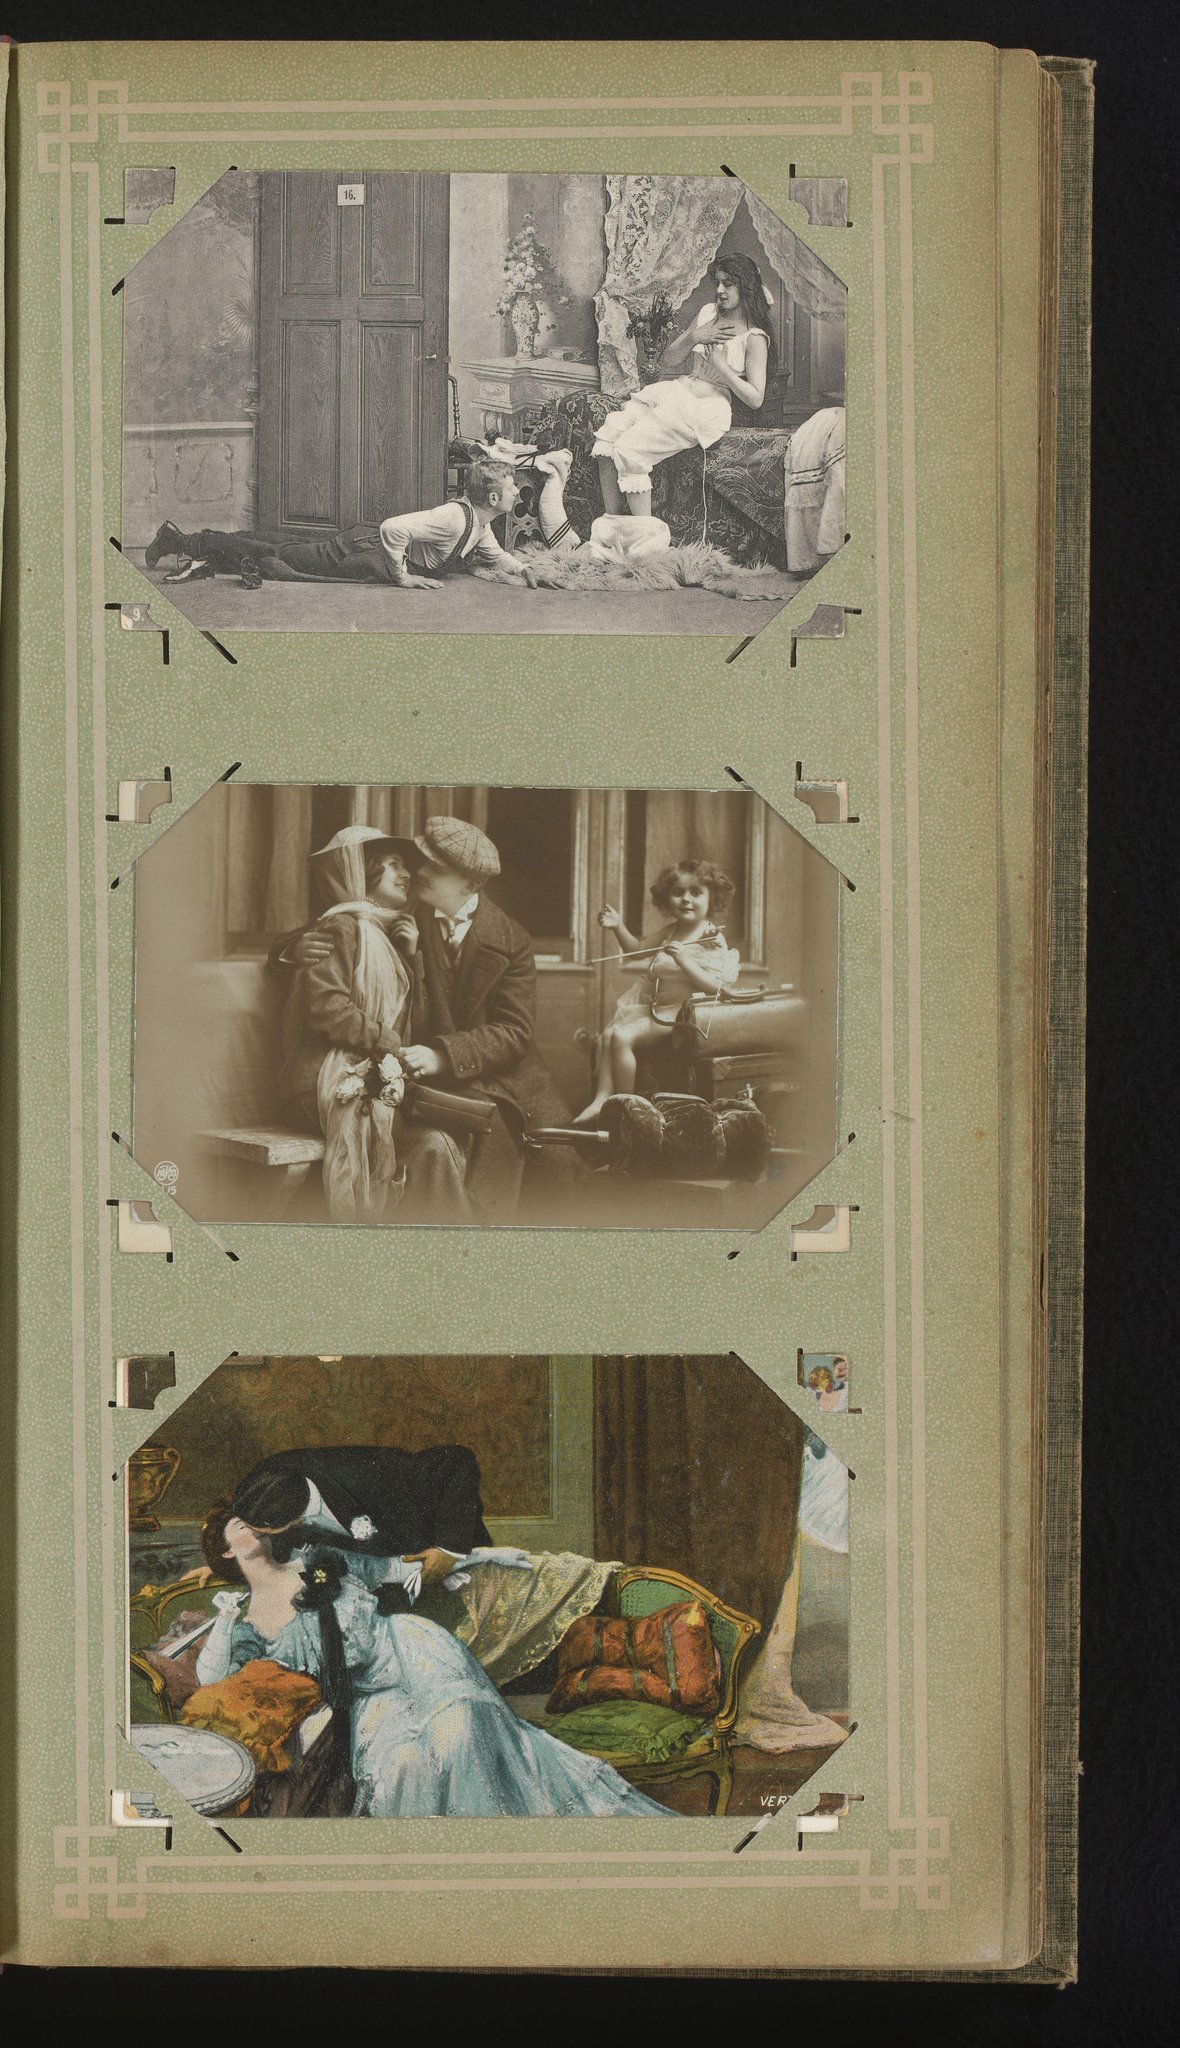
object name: photomechanical print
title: Paar geliefden in een slaapkamer en twee afbeeldingen van kussende paren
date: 1900-1930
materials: cardboard, photographic support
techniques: photograph, gelatin silver print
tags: (lovers) kissing each other, bedroom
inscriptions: monogram: ‘M [ H] B’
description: Deze foto en prenten maken deel uit van een album.